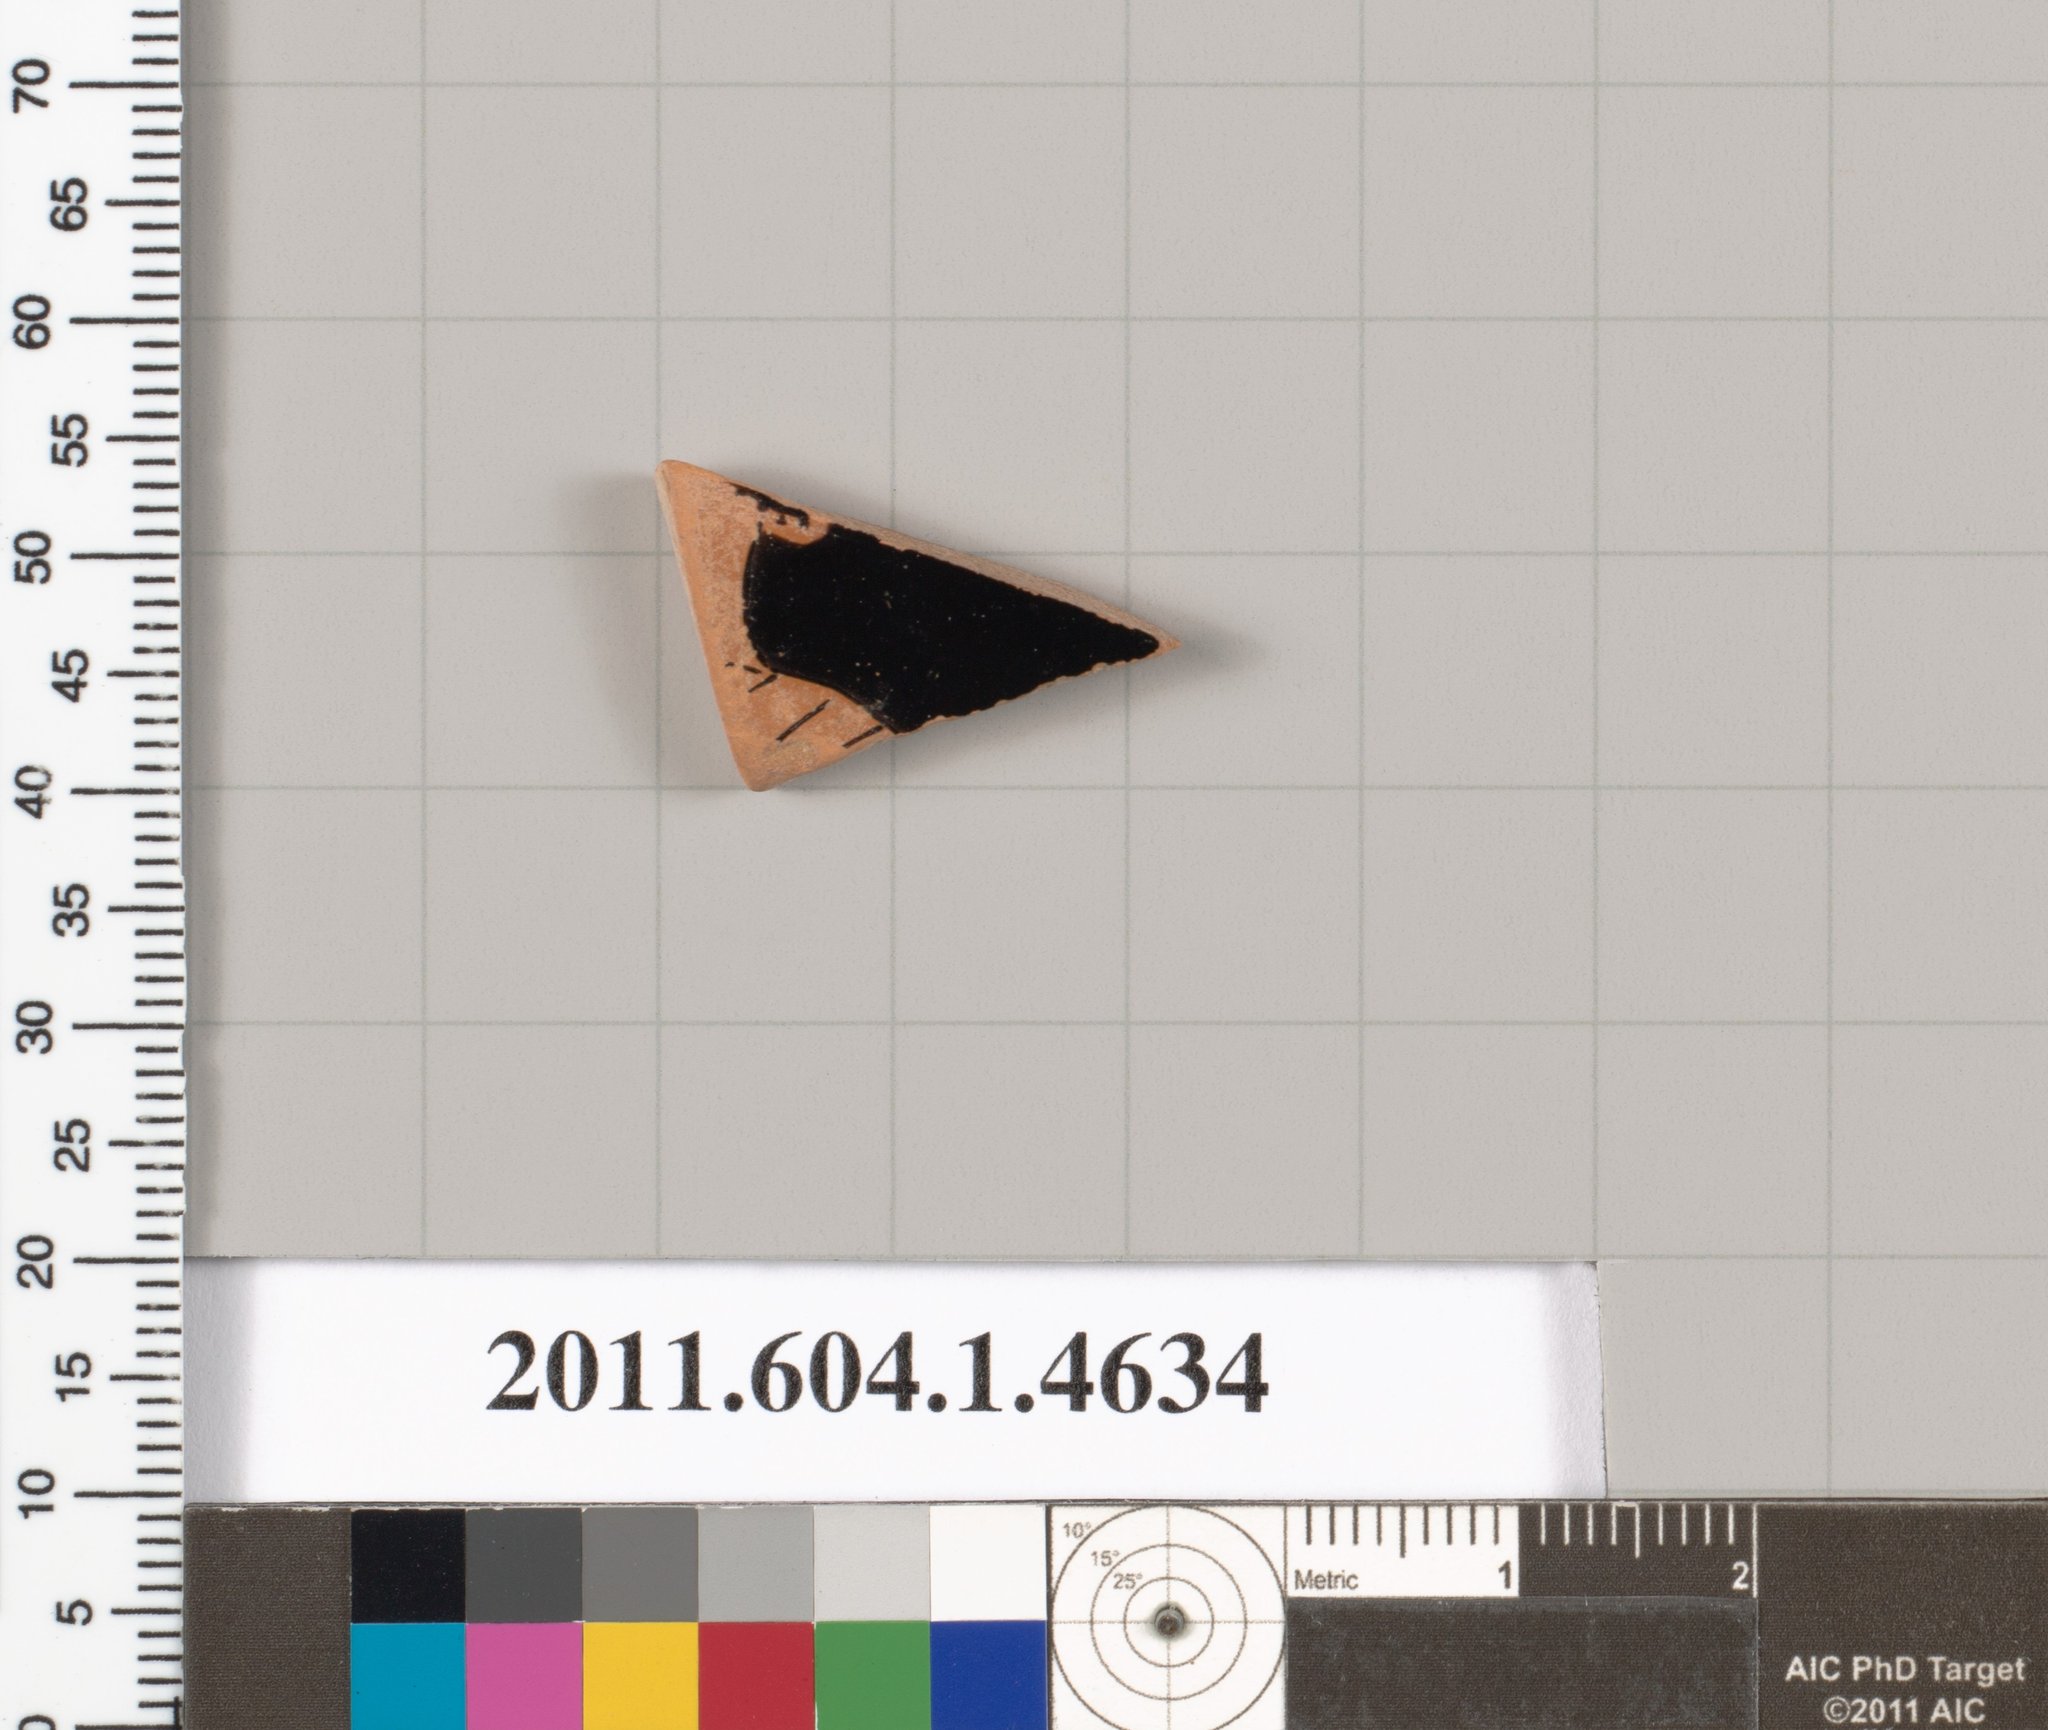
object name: kylix fragment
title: Terracotta fragment of a kylix (drinking cup)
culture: greek, attic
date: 475-451 BCE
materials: terracotta